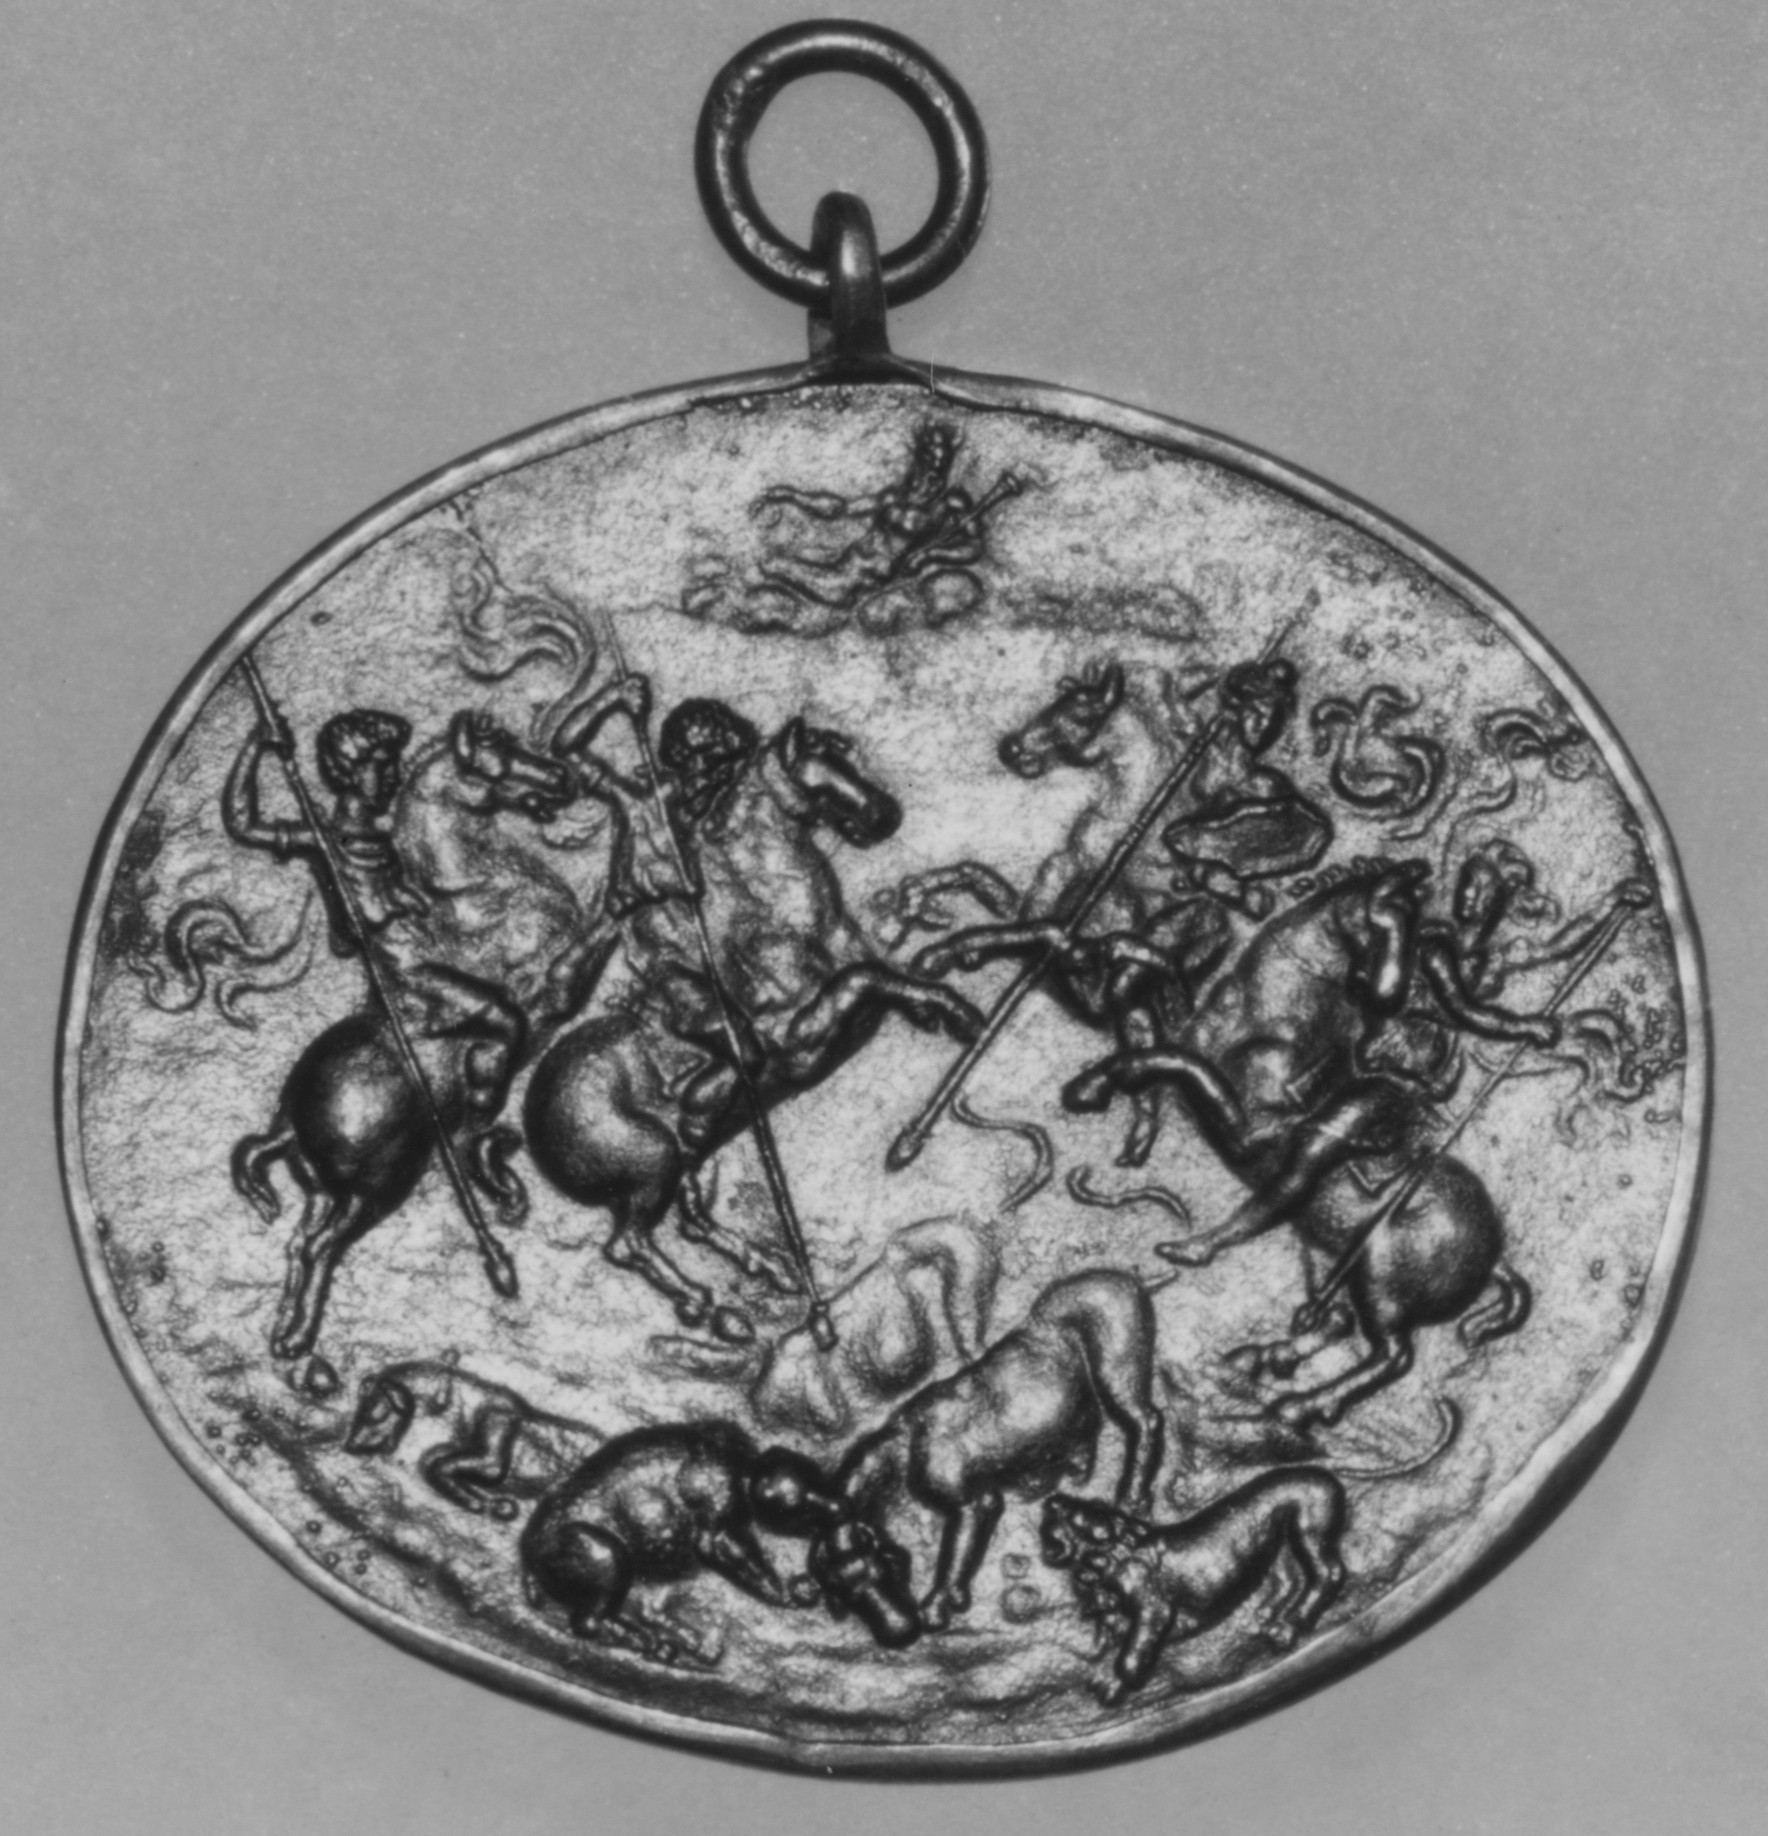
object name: plaquette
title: Bull hunt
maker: valerio belli (il vicentino)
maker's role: artist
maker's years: 1468-1546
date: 1501-1600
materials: metal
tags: men,hunting,bulls,horses